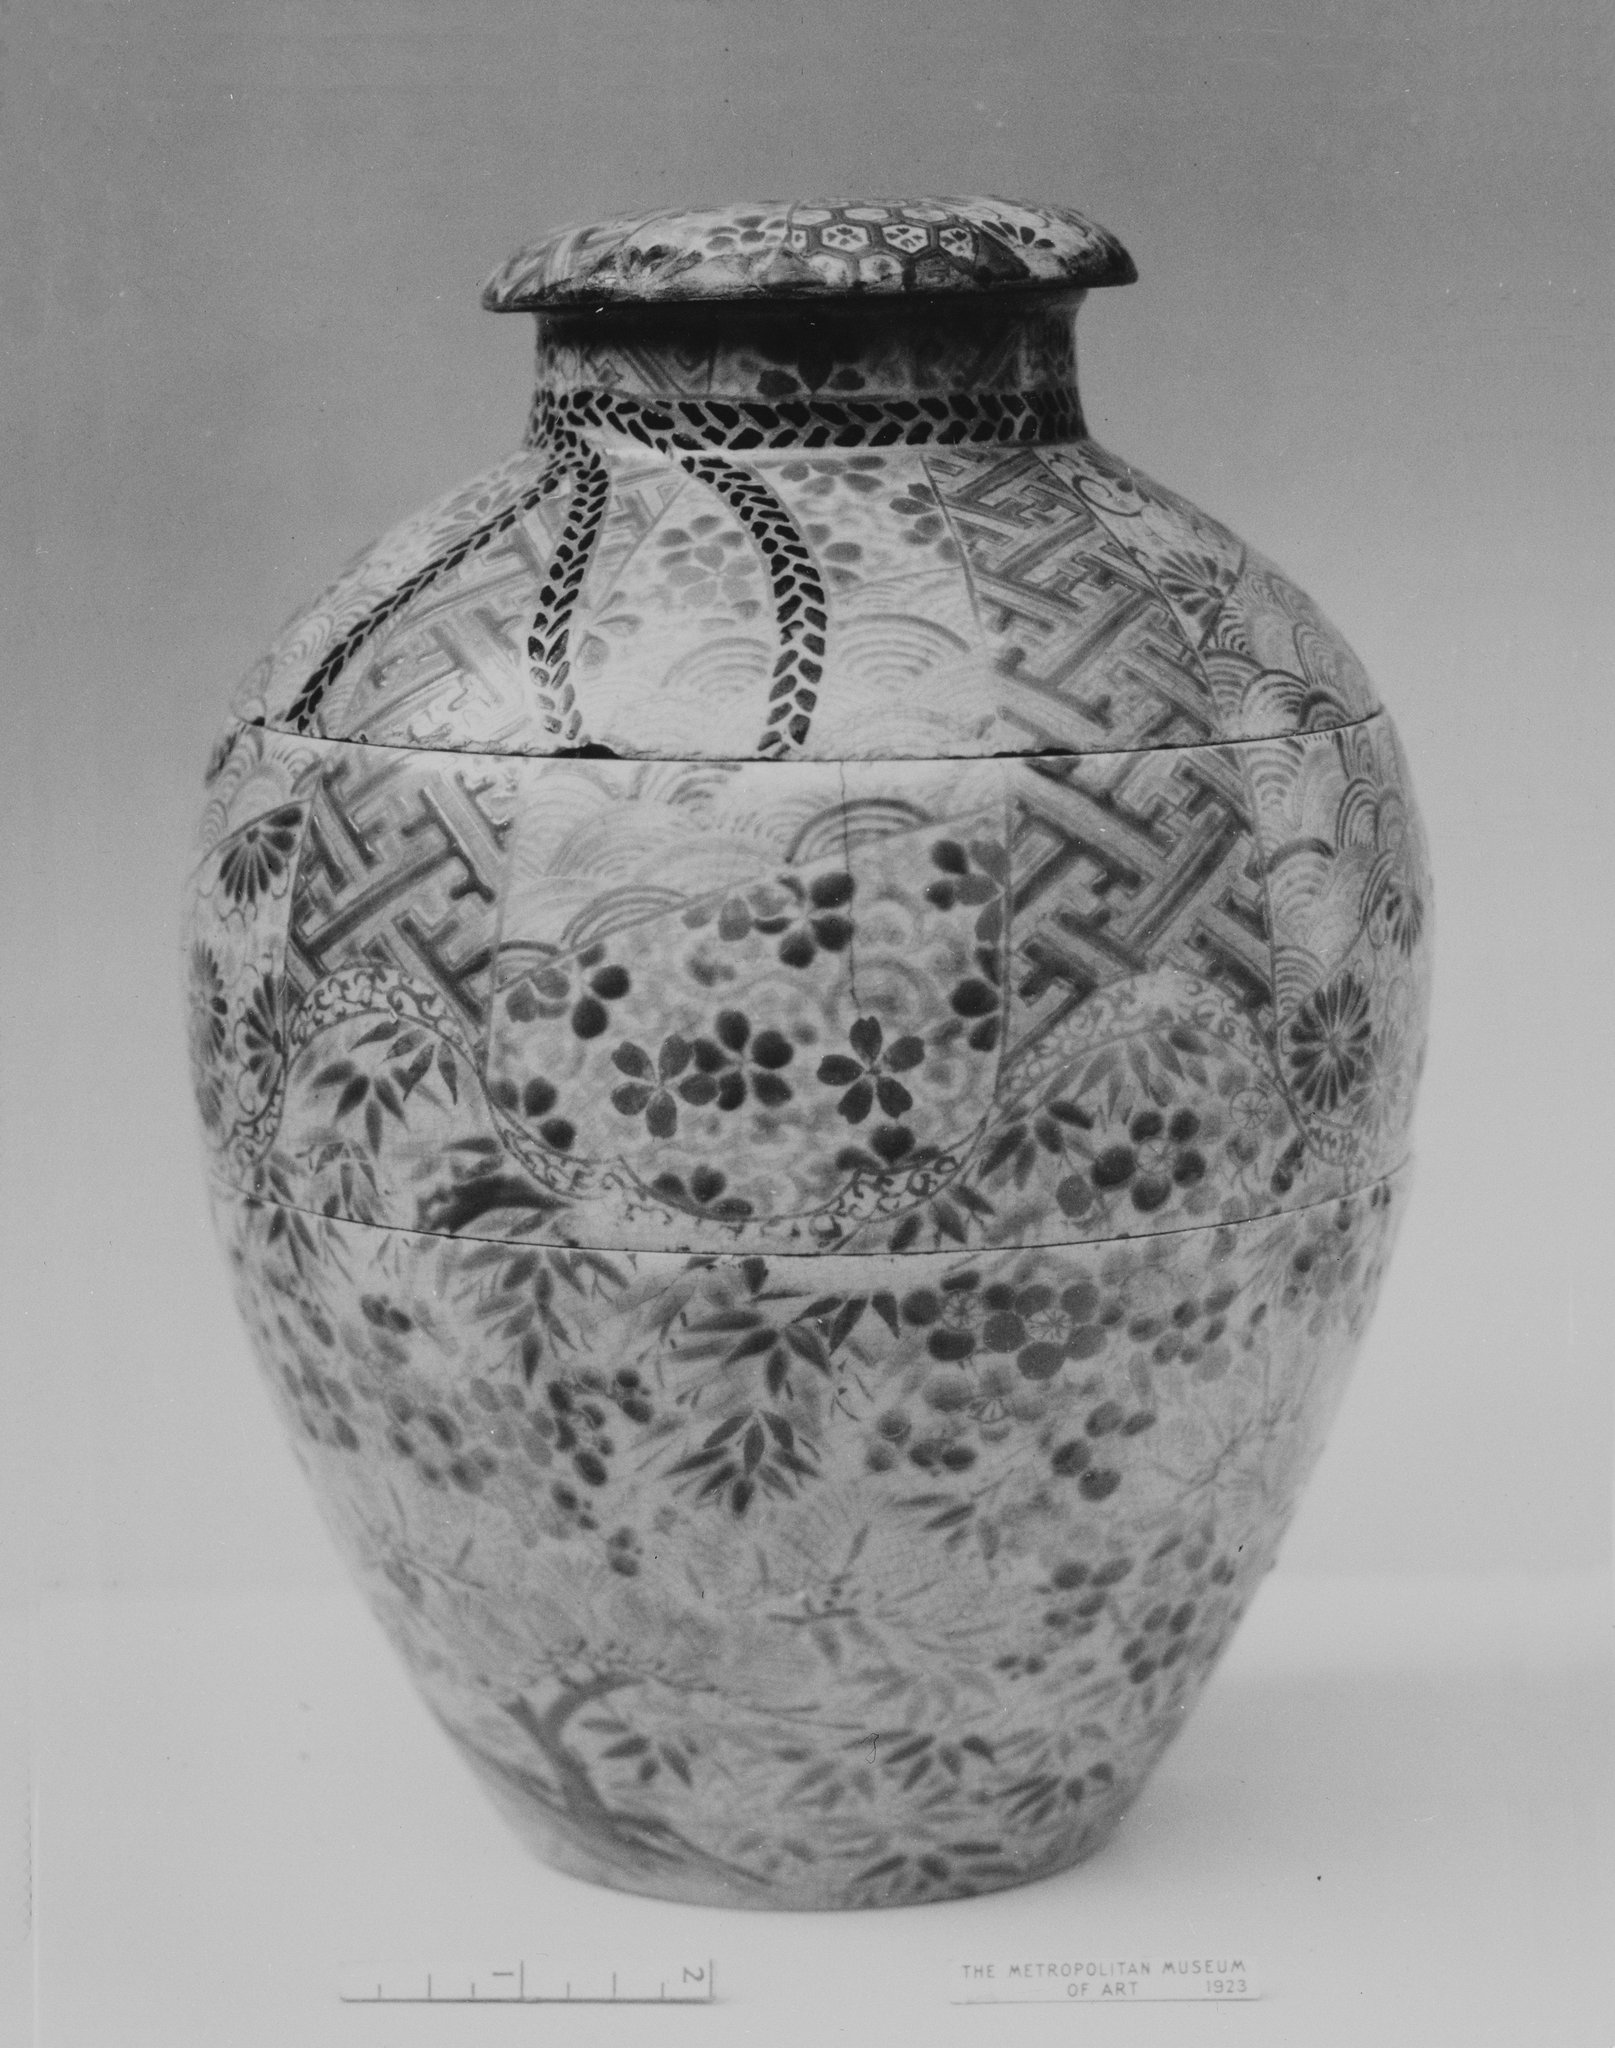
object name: cake box in tier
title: Cake box in tiers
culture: japanese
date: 1780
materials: enamel, faience, glaze